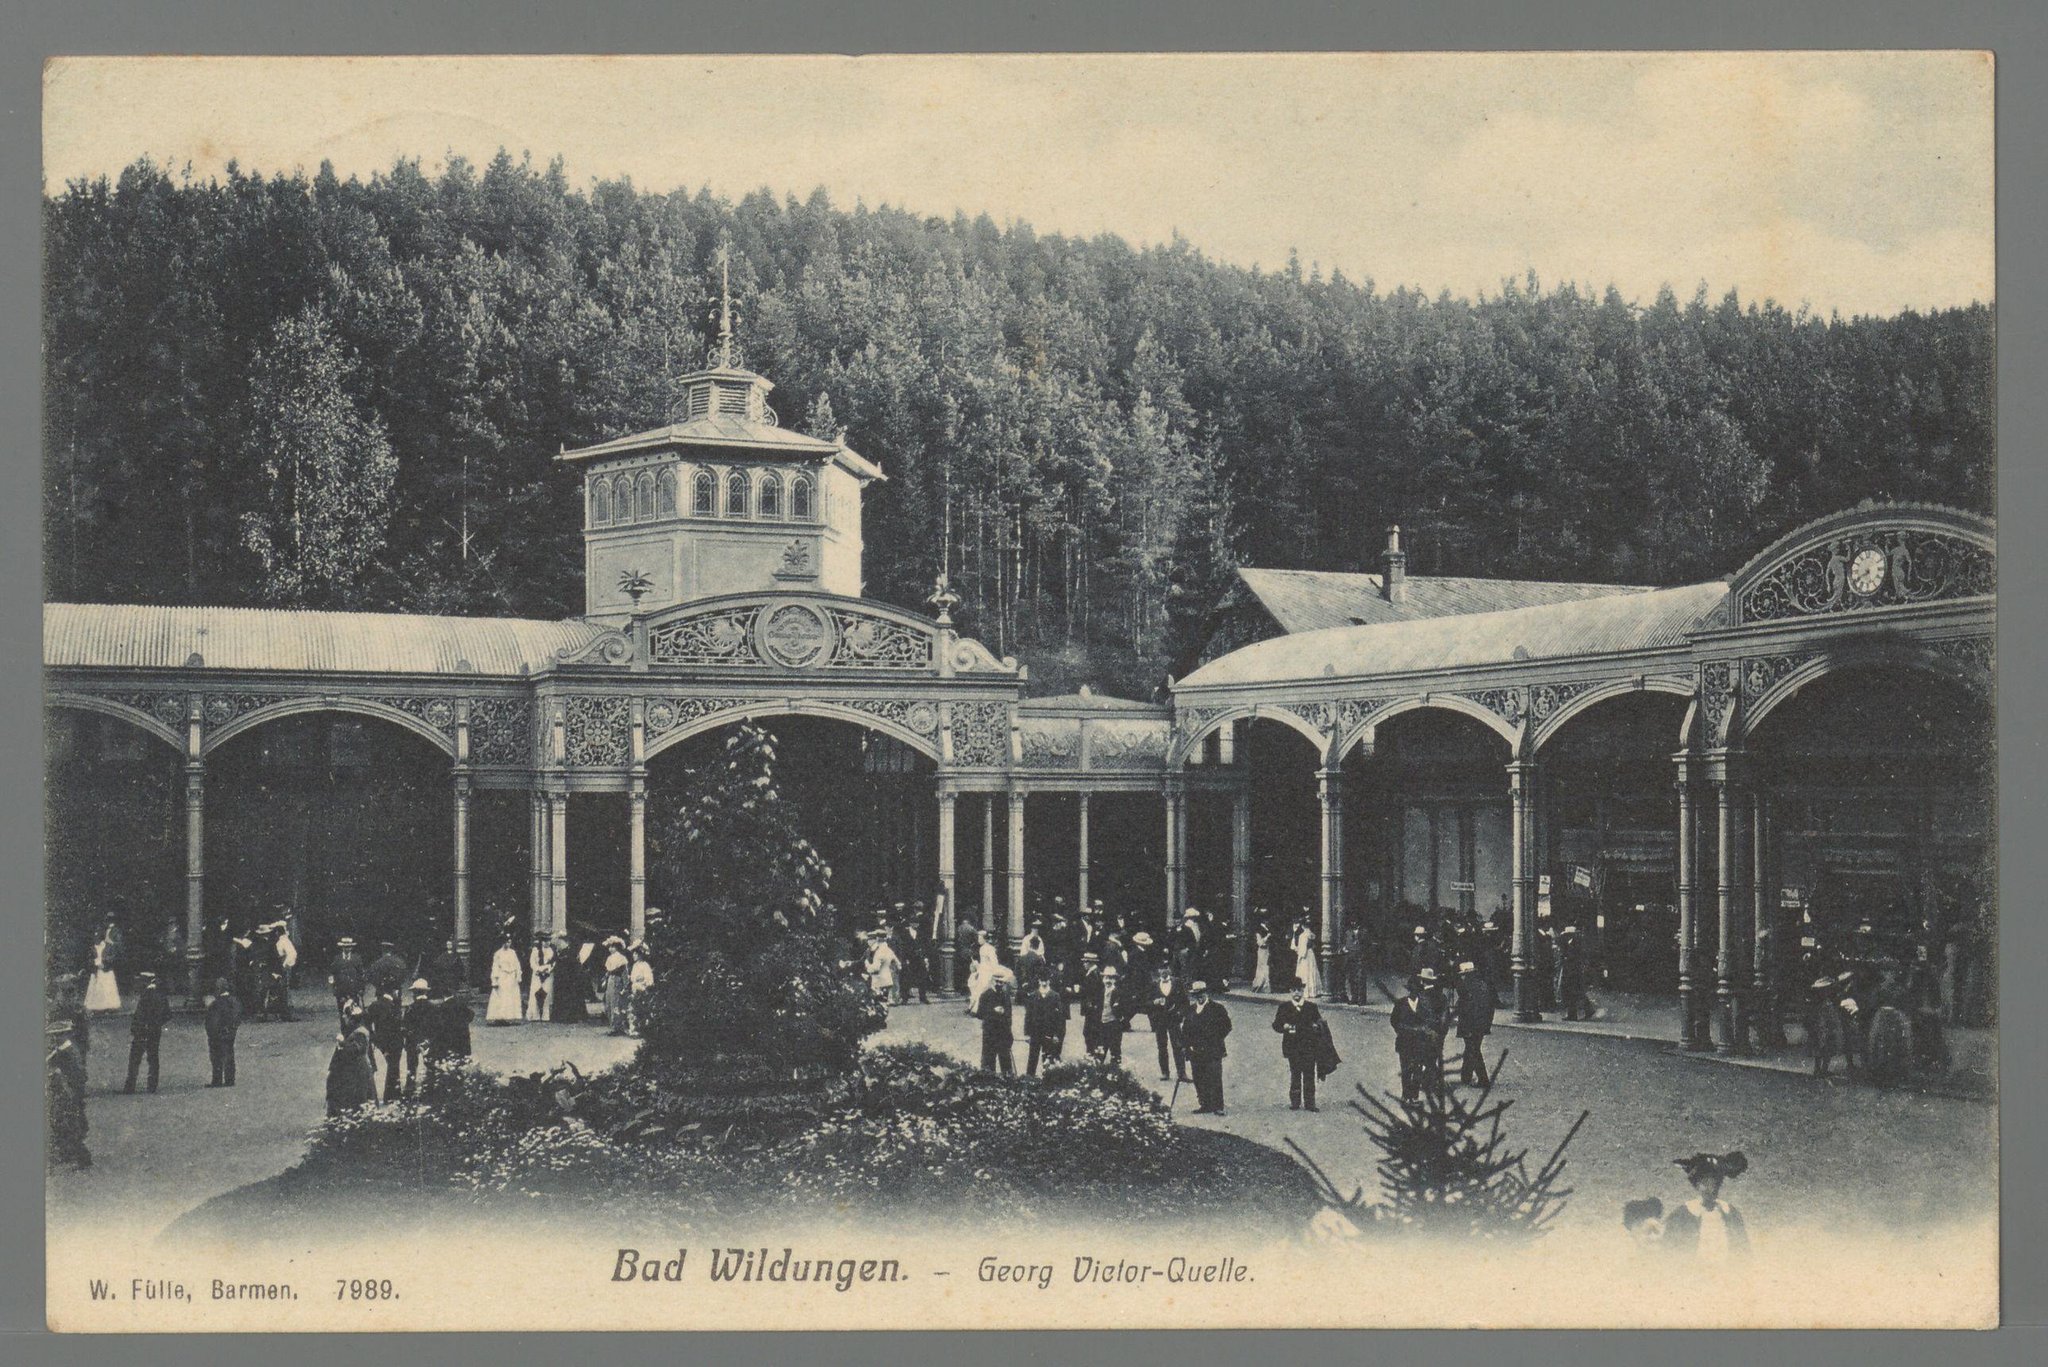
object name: photomechanical print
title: Bad Wildungen Georg Victor-Quelle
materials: cardboard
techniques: photograph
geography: barmen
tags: well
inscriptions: postage stamp